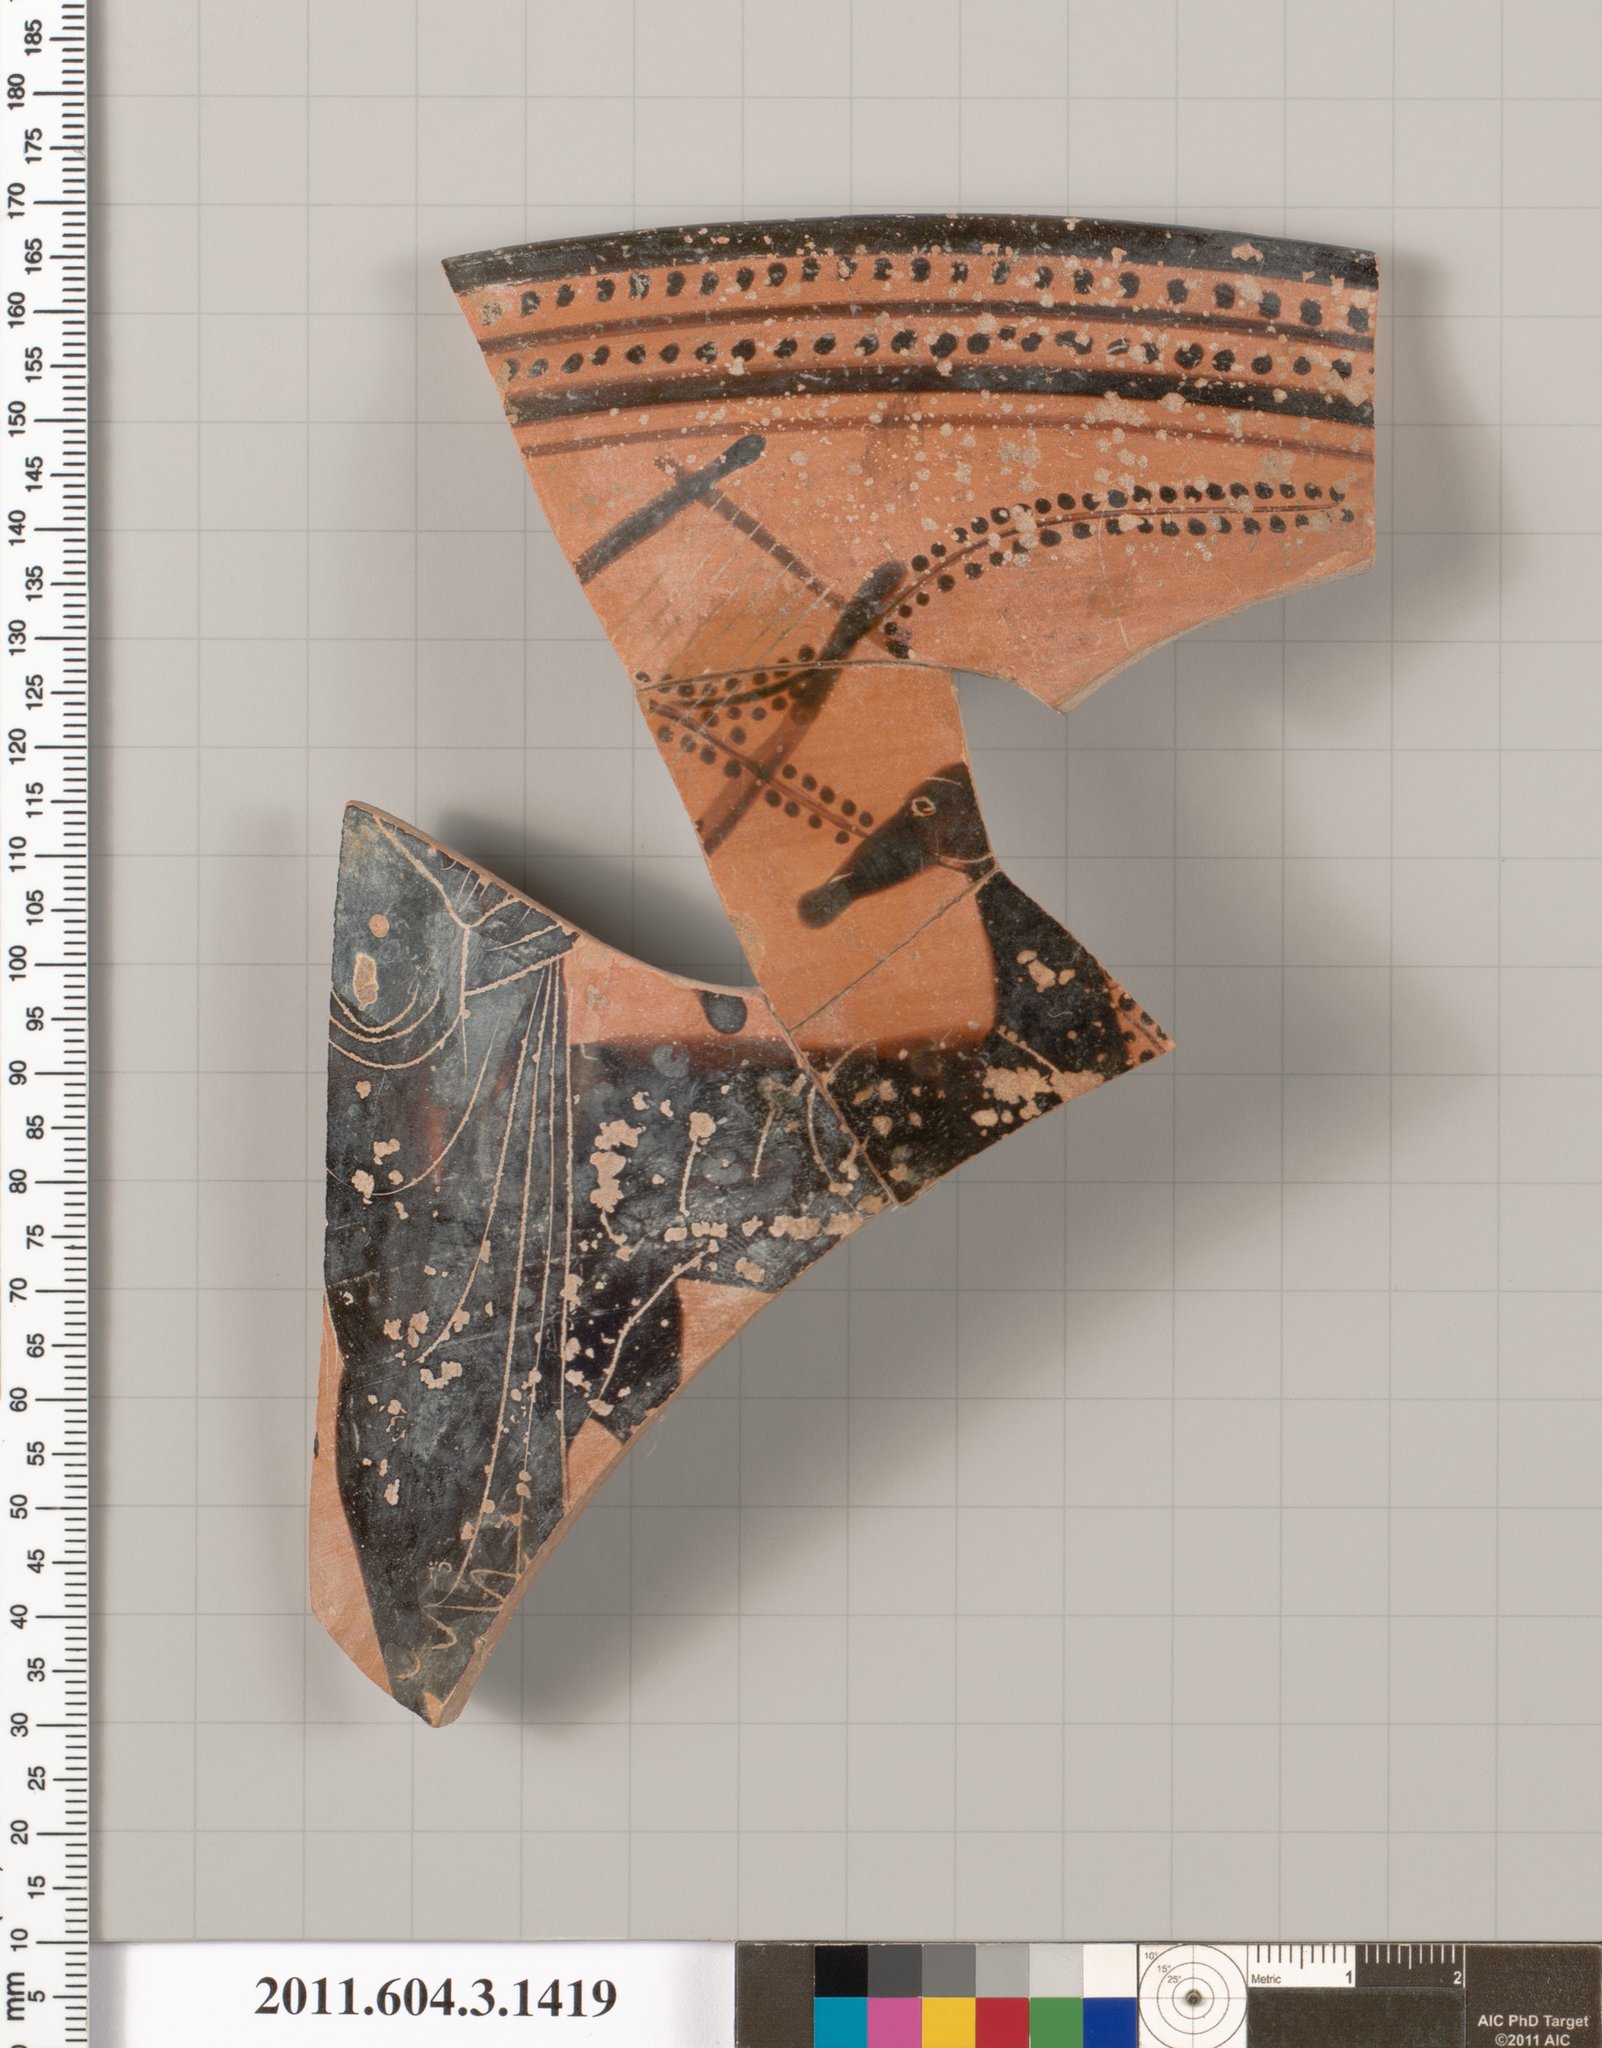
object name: skyphos fragment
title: Terracotta rim fragment of a skyphos (deep drinking cup)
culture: greek, attic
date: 500-468 BCE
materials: terracotta